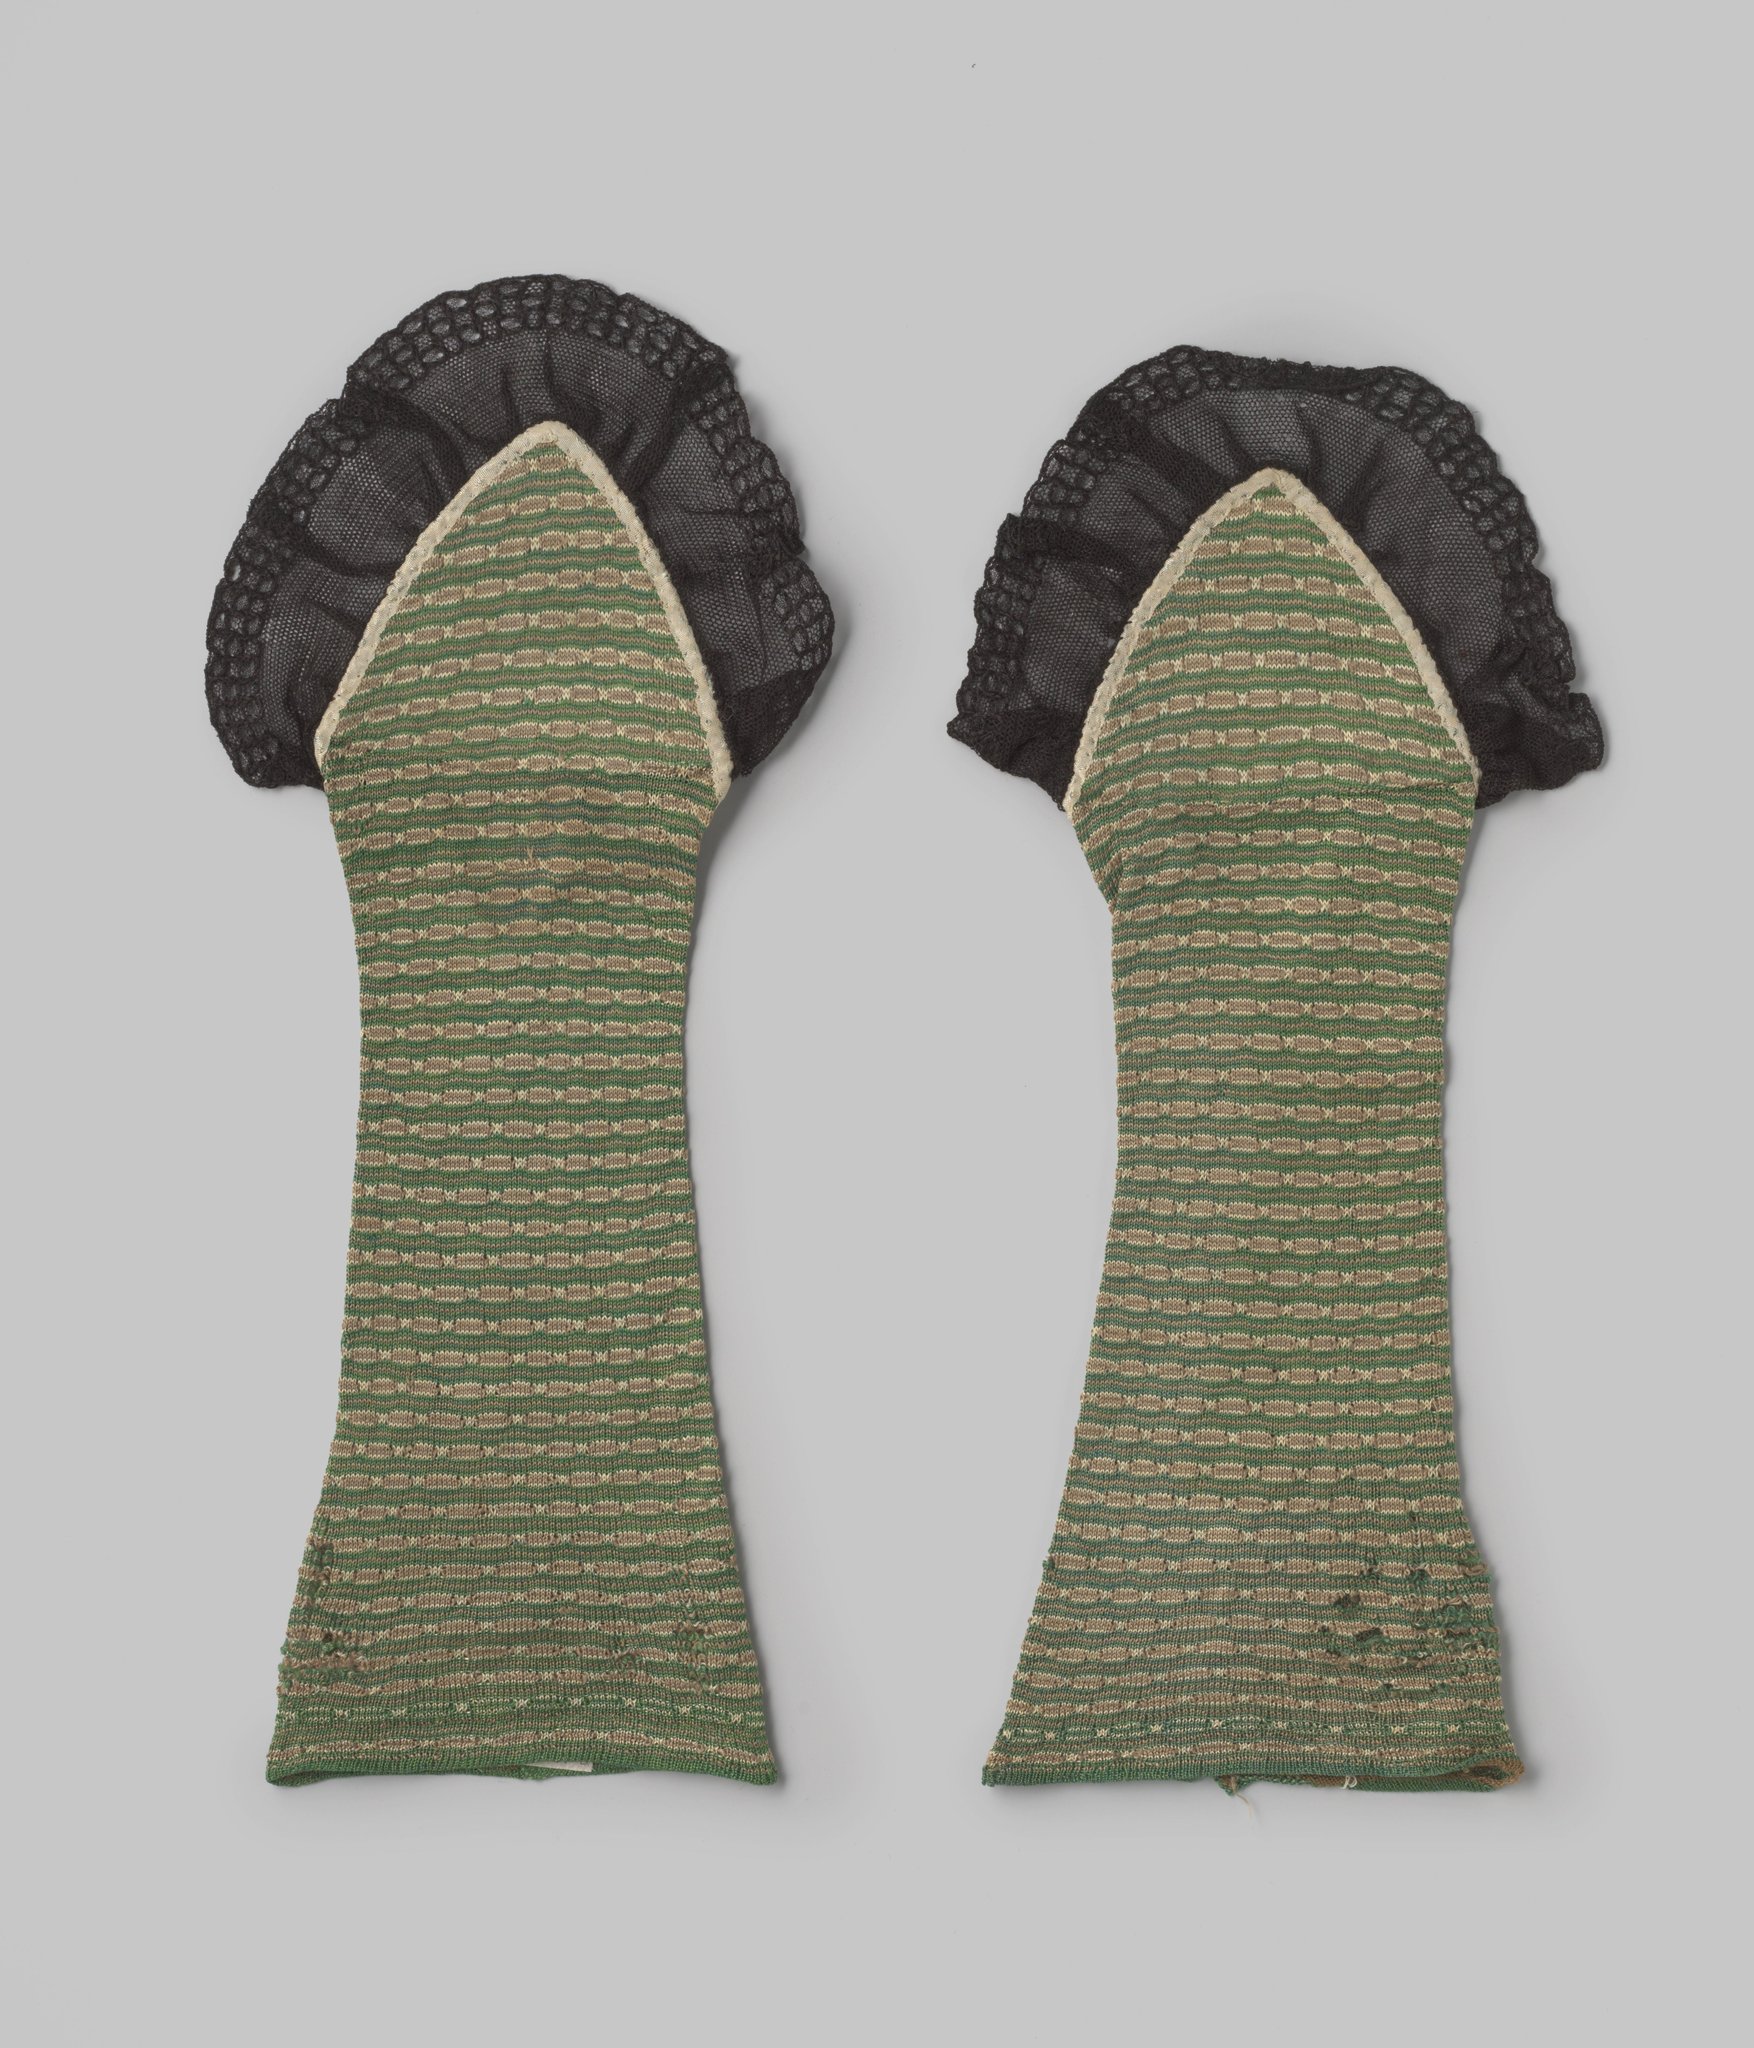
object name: mitt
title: Mitaine van zijde, groen, beige en witgestreept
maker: Anonymous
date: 1800-1820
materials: silk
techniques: knitting, quilting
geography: zaanstreek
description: Een paar zijden mitaines in de breedte afwisselend groen met grijs en grijs met wit gestreept. Aan de onderzijde van zwarte kant voorzien.